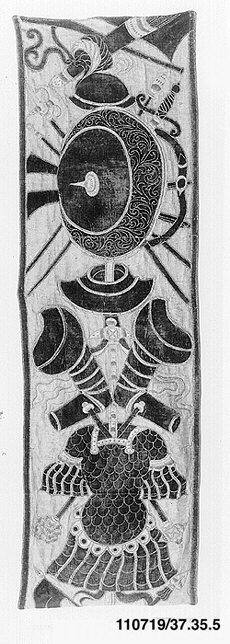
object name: hanging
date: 1550-1600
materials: metal thread, silk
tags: armor